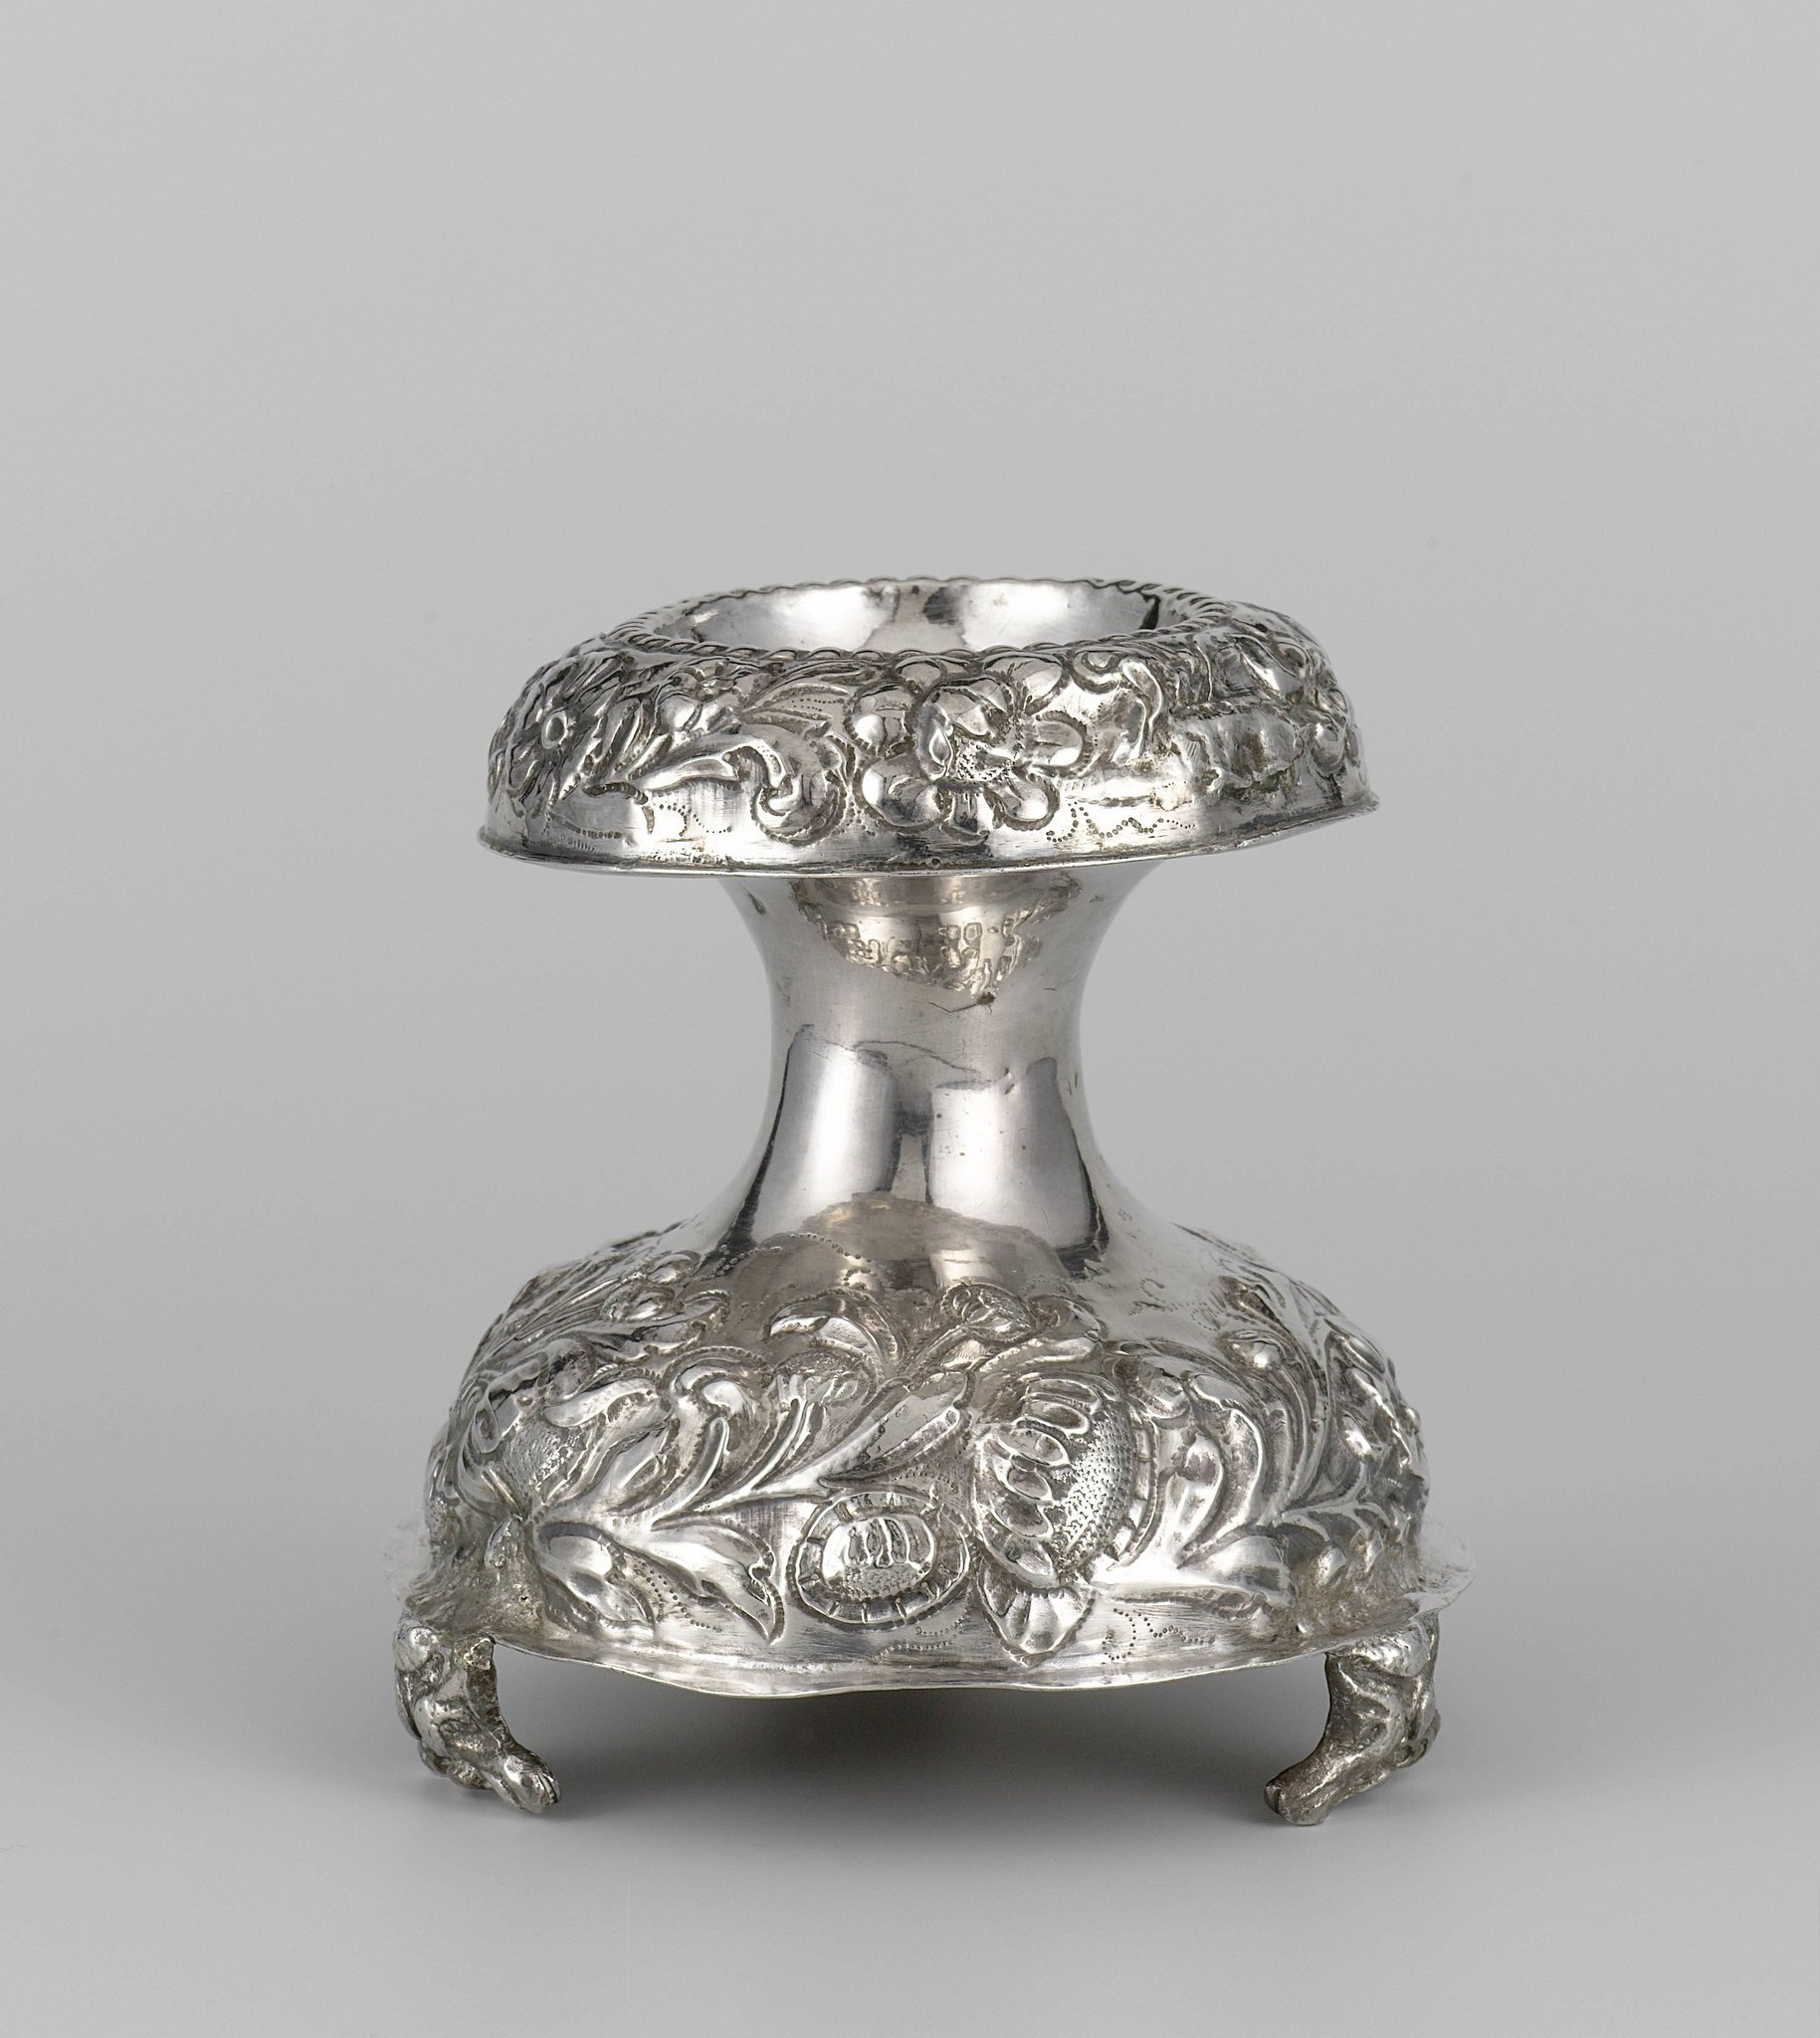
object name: salt condiment vessel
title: Zoutvat met bloem- en bladranken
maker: abraham marshoorn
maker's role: silversmith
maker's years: 1683-1756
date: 1711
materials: silver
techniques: metalworking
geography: haarlem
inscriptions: town mark: ‘Hollandse leeuw’, initials: ‘NS IS’, duty mark: ‘bijltje’, date letter: ‘D’, maker's mark: ‘hoorn in schild’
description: Het ronde, diabolo-vormige zoutvat heeft een vlakke onderrand en rust op drie afzonderlijke poten, die elk een kwabmotief vertonen. Het lichaam verjongt zich naar een smal middengedeelte dat zich aan de bovenzijde verbreedt en wordt afgesloten door een vlakke rand. De bovenzijde toont een bolle rand, die het gladde komvormige vat omsluit. De onderzijde van het lichaam en de bolle bovenrand zijn versierd met bladranken, waarin bloemen zijn opgenomen. Onder andere te onderscheiden zijn rozen en anemonen. Langs de rand van het vat zijn ribben aangebracht.